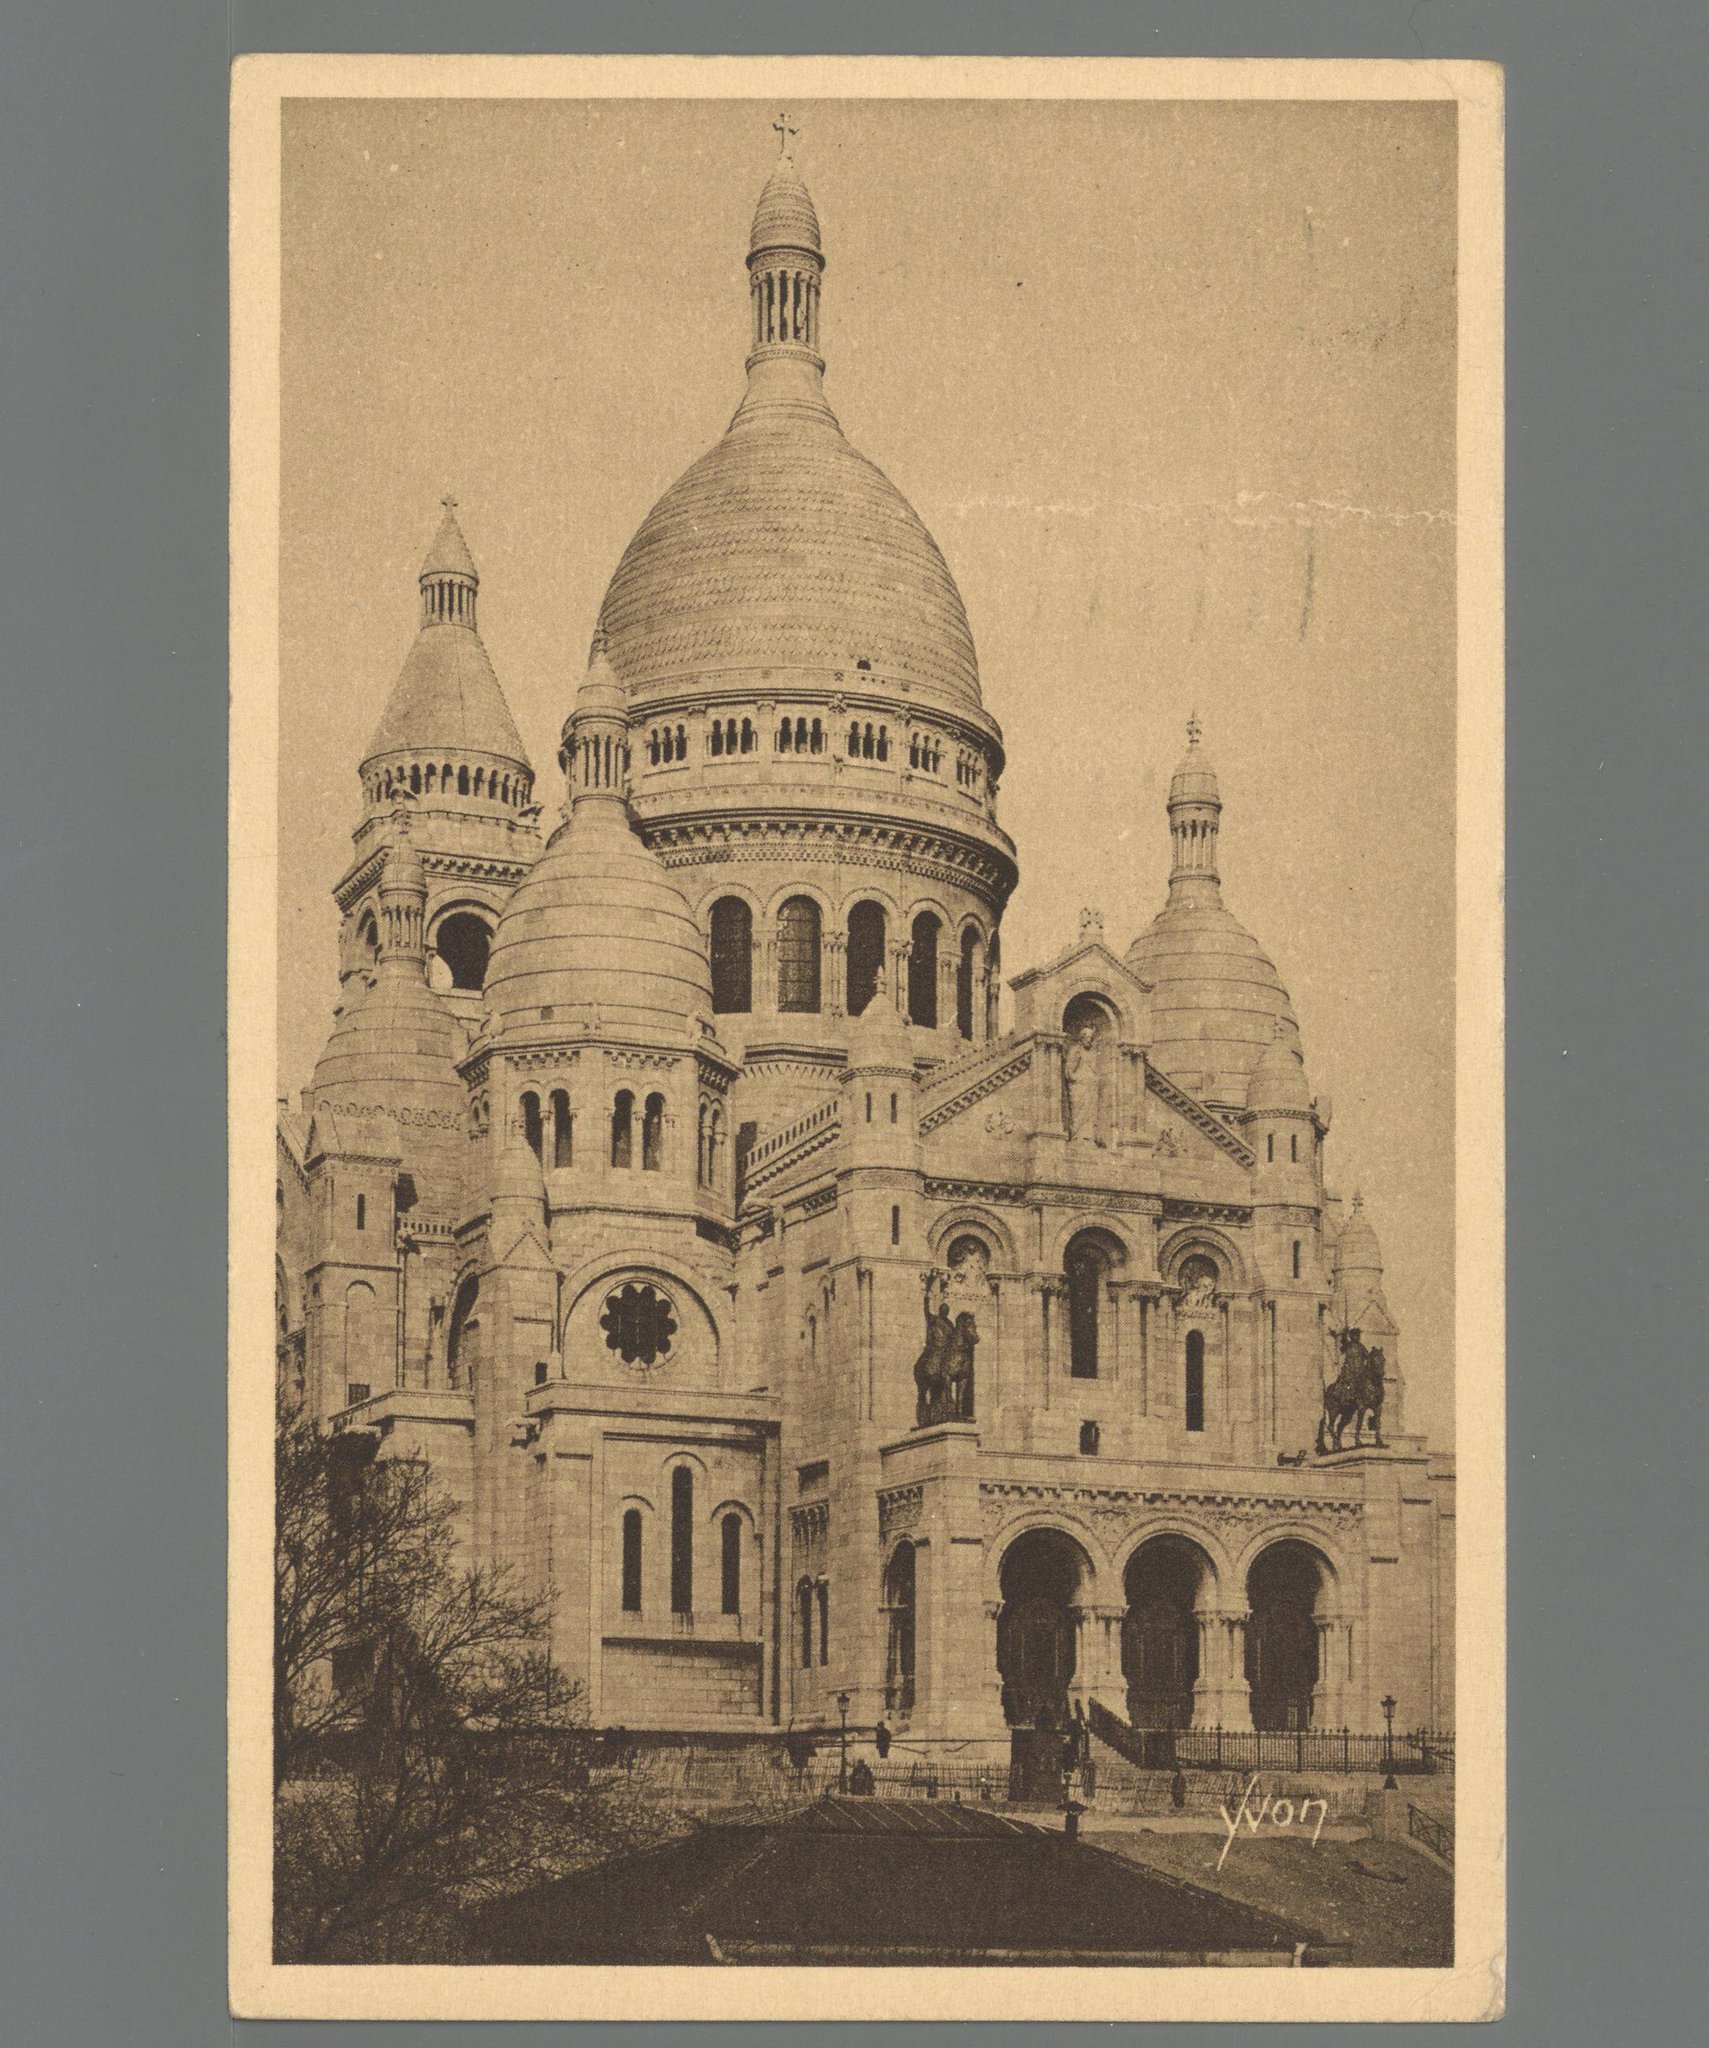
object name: ansichtkaart, prentbriefkaart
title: La Basilique du Sacré-Coeur / The Basilica of the Sacred-Heart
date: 1903-1930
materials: cardboard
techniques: rotogravure, writing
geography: paris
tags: church (exterior)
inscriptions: postage stamp